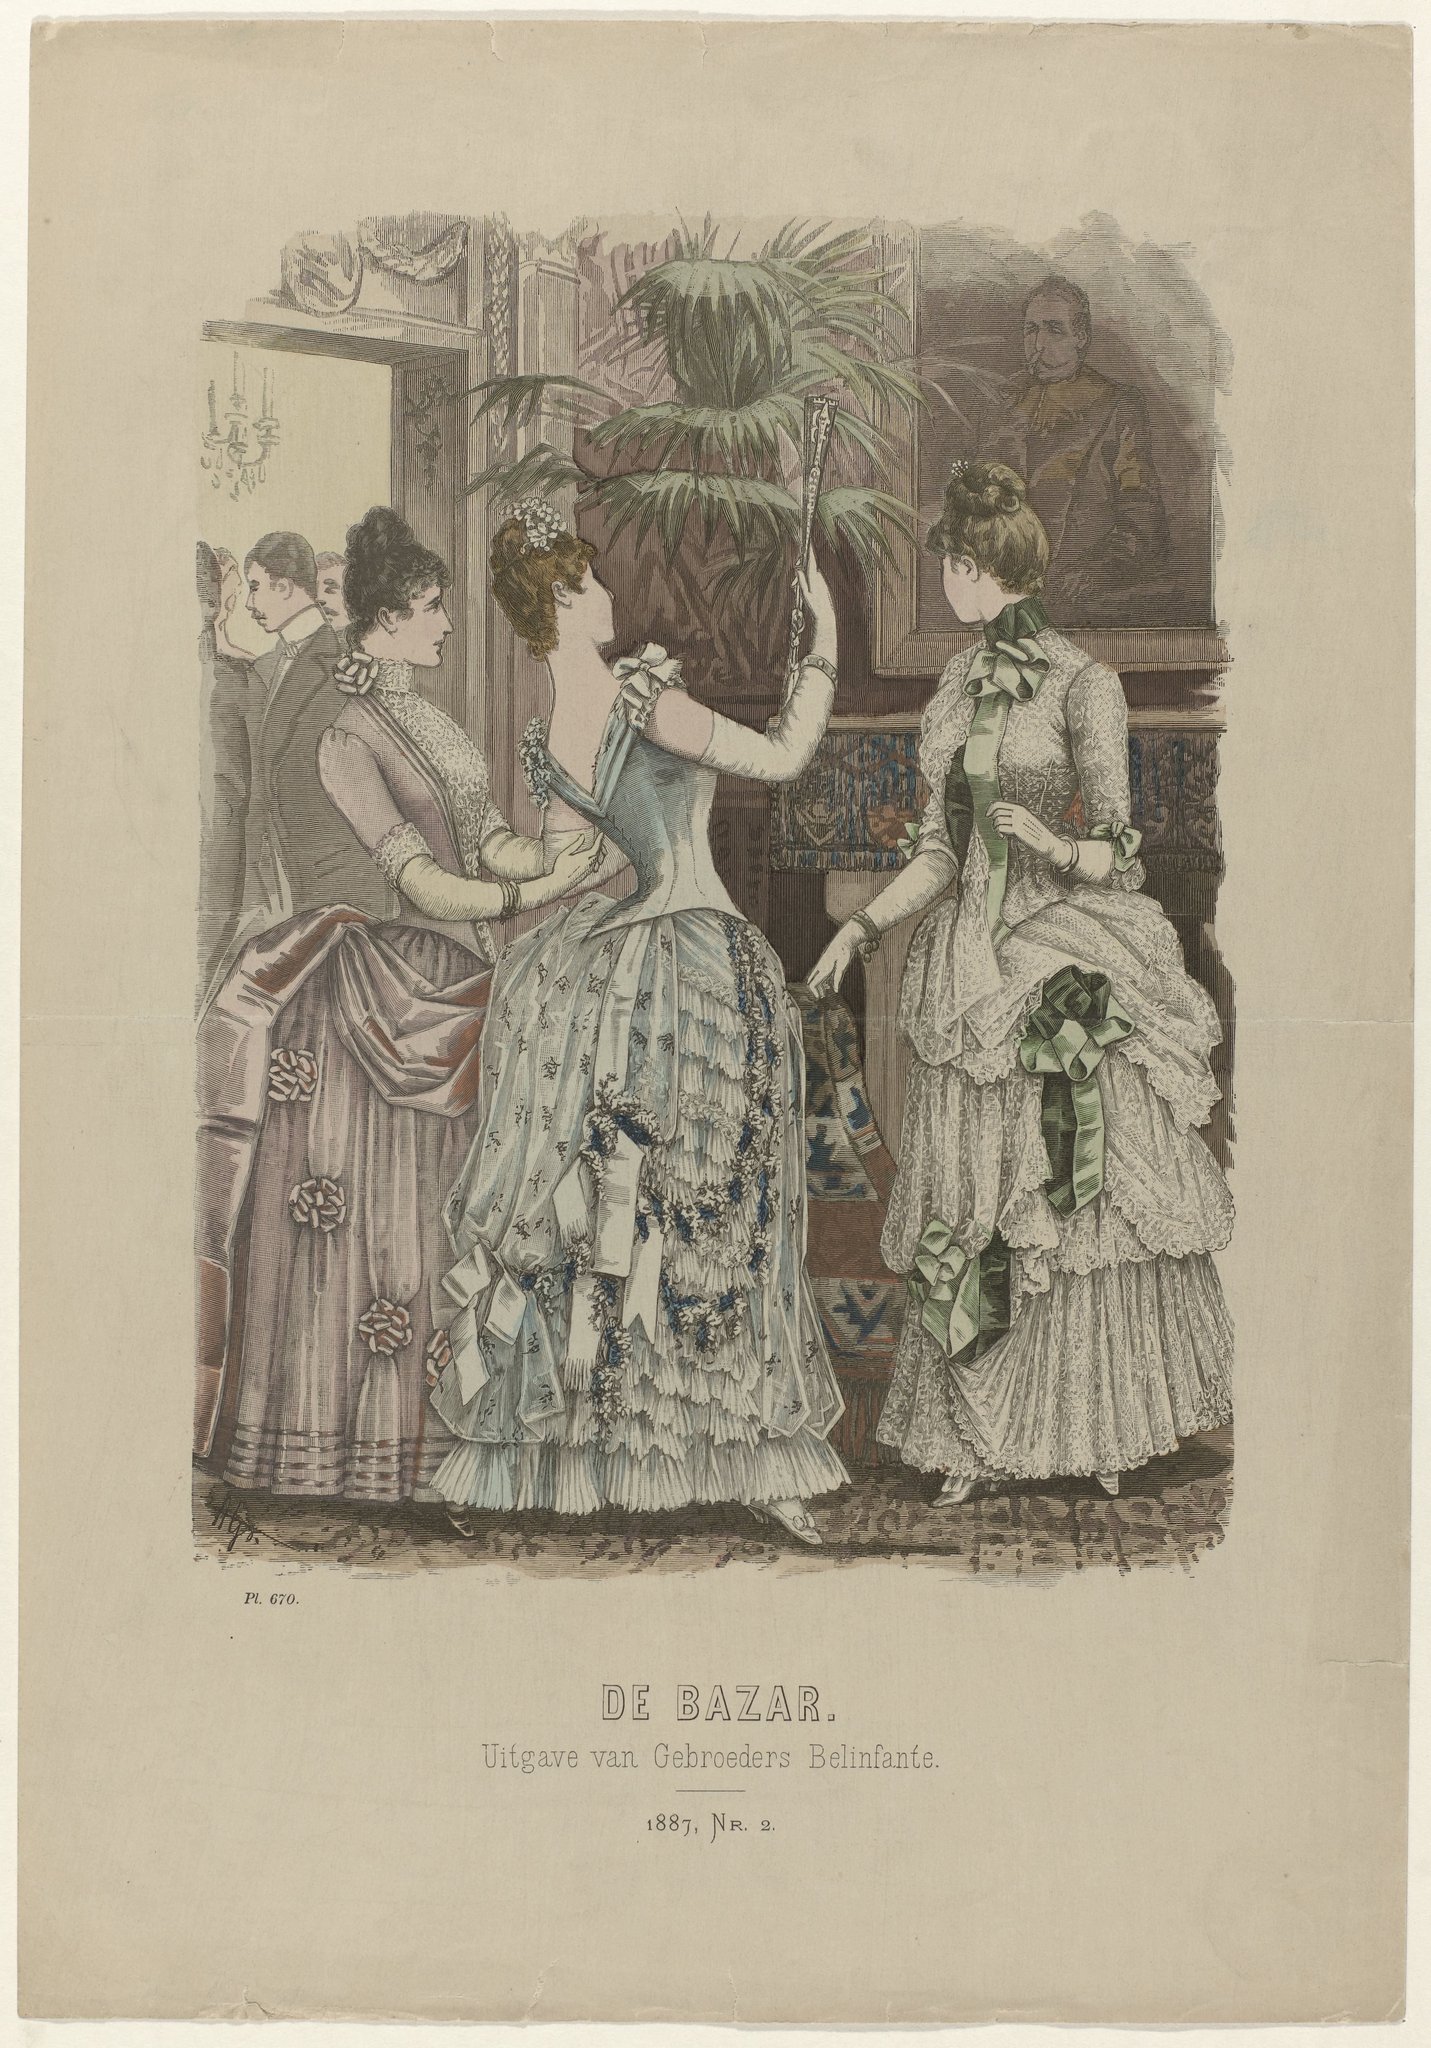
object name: fashion print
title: De Bazar, 1887, Nr. 2, Pl. 670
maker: Anonymous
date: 1887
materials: paper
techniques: hand coloring, engraving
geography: the hague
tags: dress, gown: evening dress (+ women's clothes), gloves, mittens (long gloves) (+ women's clothes), border, ribbon, braid (+ women's clothes), fashion plates, fan (+ women's clothes), bracelet, wristlet (+ women's clothes)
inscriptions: caption: ‘DE BAZAR. / Uitgave van Gebroeders Belinfante. / 1887, Nr. 2’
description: Prent uit het modetijdschrift De Bazar, geïllustreerd Tijdschrift voor Modes en Handwerken (1857-1900).